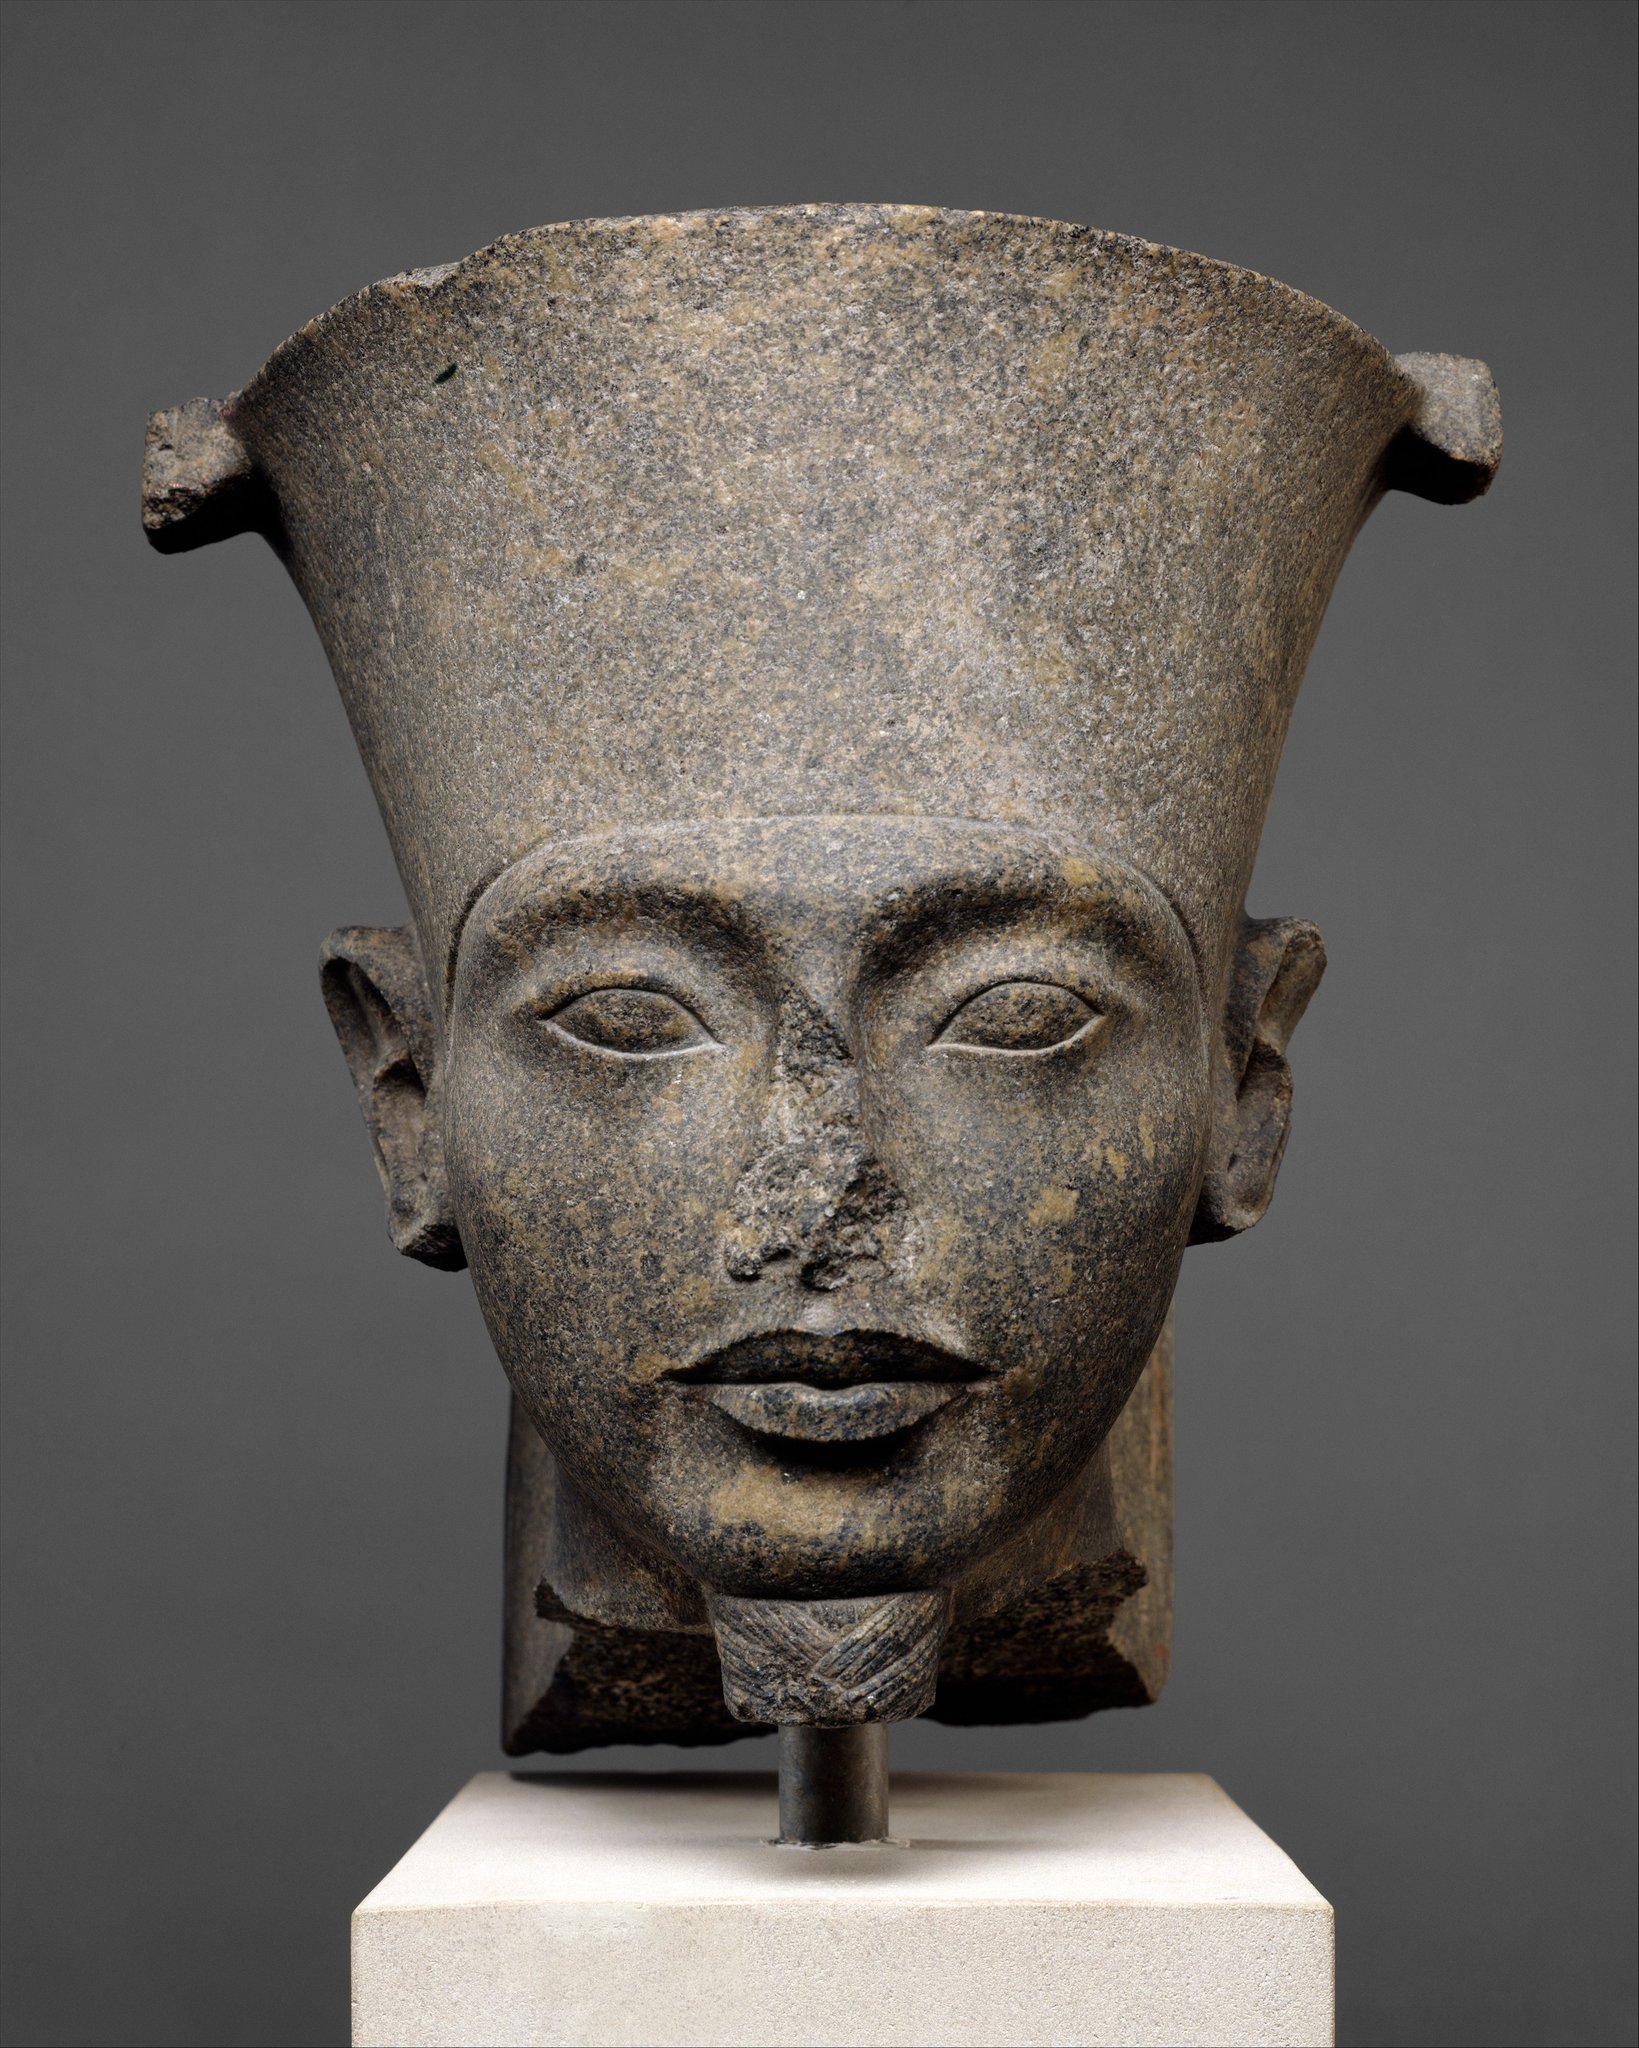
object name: head, amun, tutankhamun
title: Head of the god Amun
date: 1336-1327 BCE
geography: upper egypt, thebes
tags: heads,amun,gods